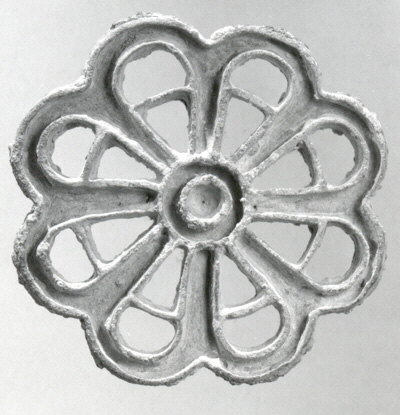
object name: stamp seal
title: Compartmented stamp seal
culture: bactria-margiana archaeological complex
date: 2333-1668 BCE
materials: copper alloy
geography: bactria-margiana